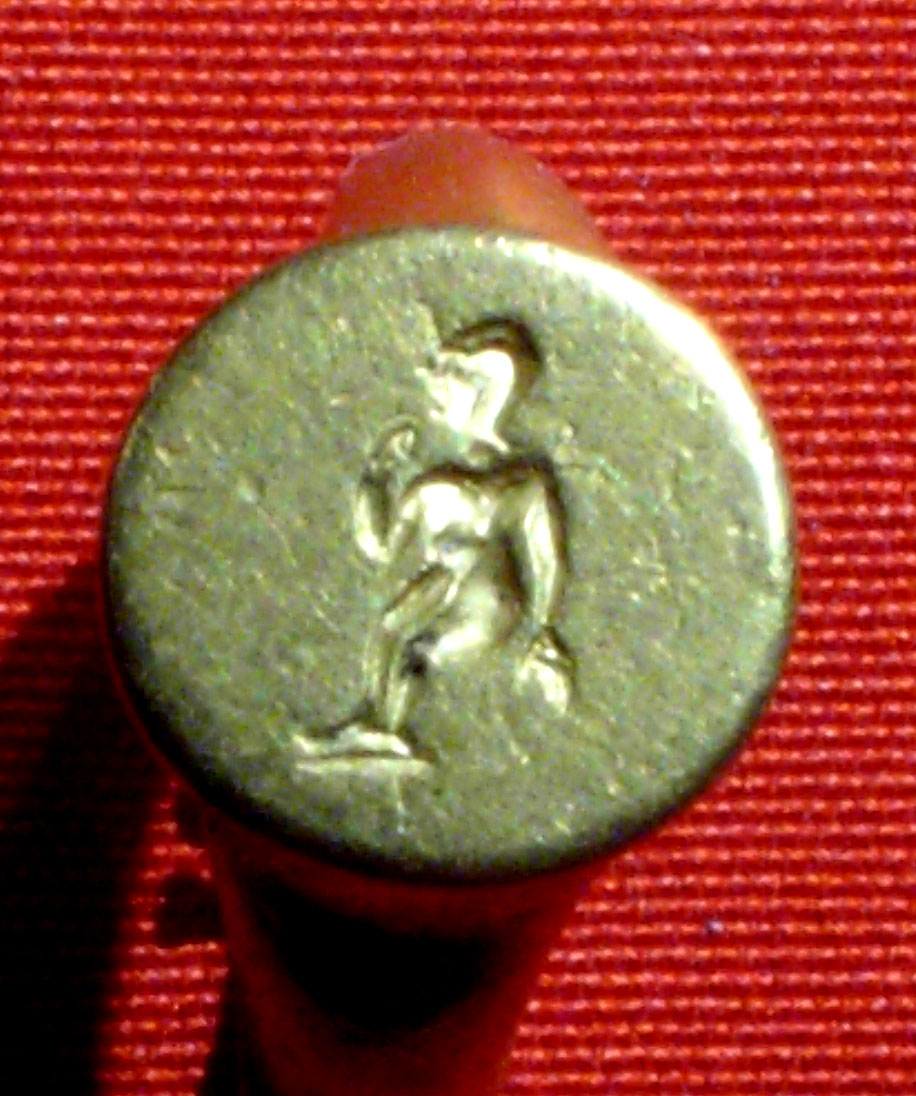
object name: ring, intaglio, harpokrates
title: Ring with intaglio of Harpokrates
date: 200 BCE-100 CE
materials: gold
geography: egypt